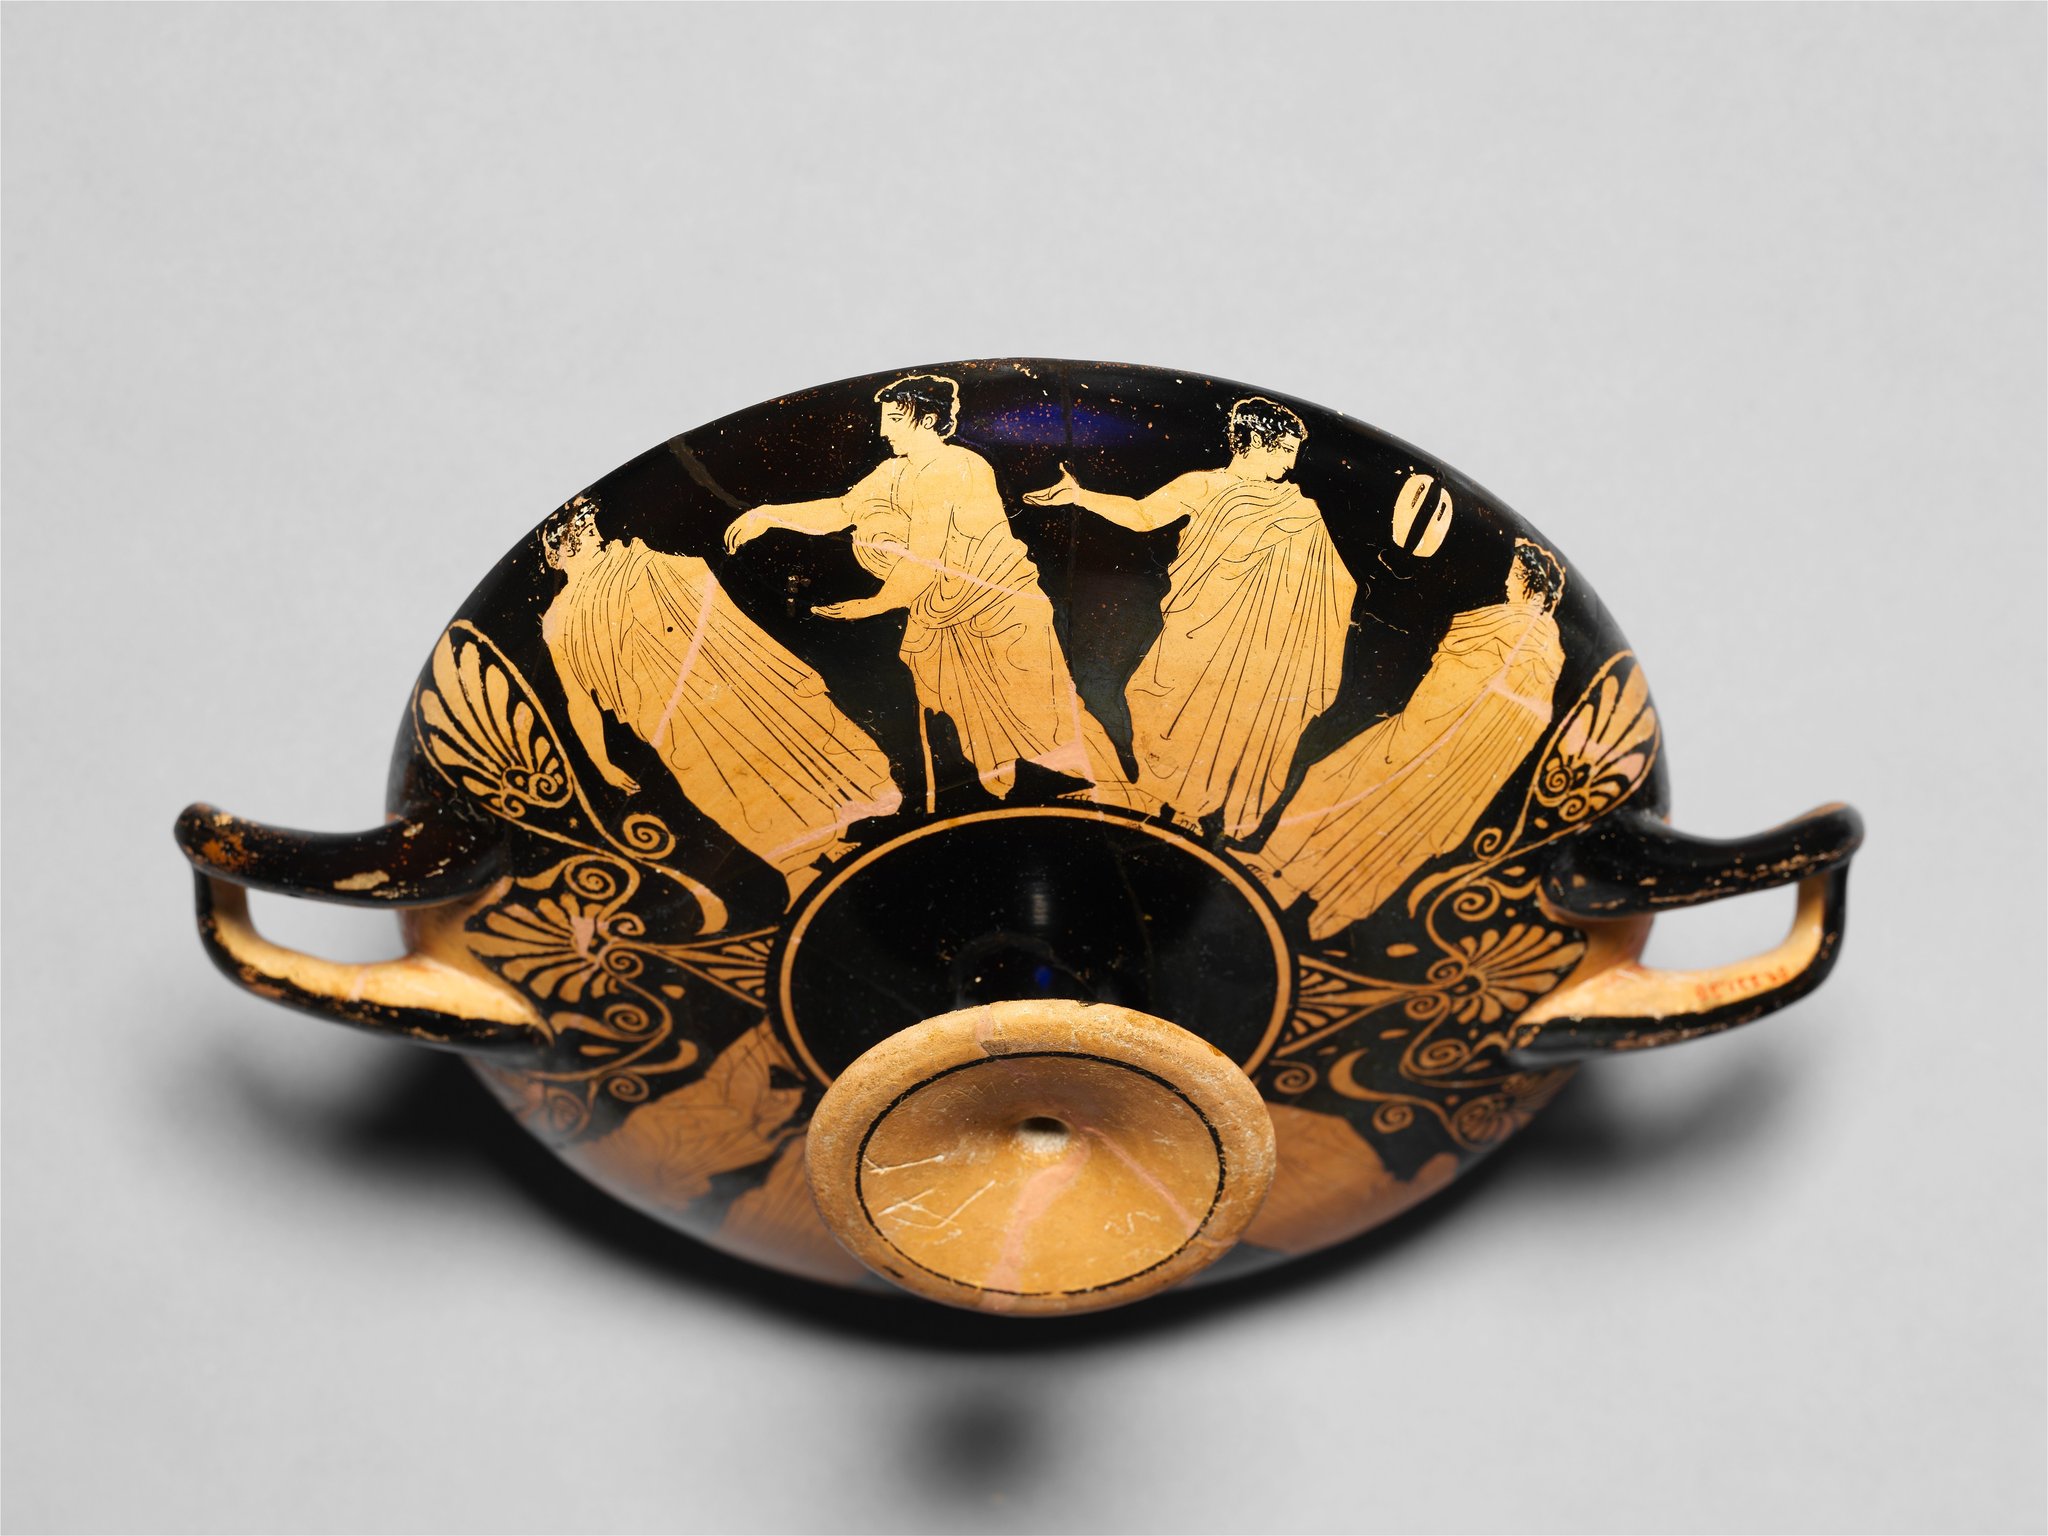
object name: kylix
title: Terracotta kylix (drinking cup)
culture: greek, attic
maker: washing painter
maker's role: artist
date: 420 BCE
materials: terracotta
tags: men